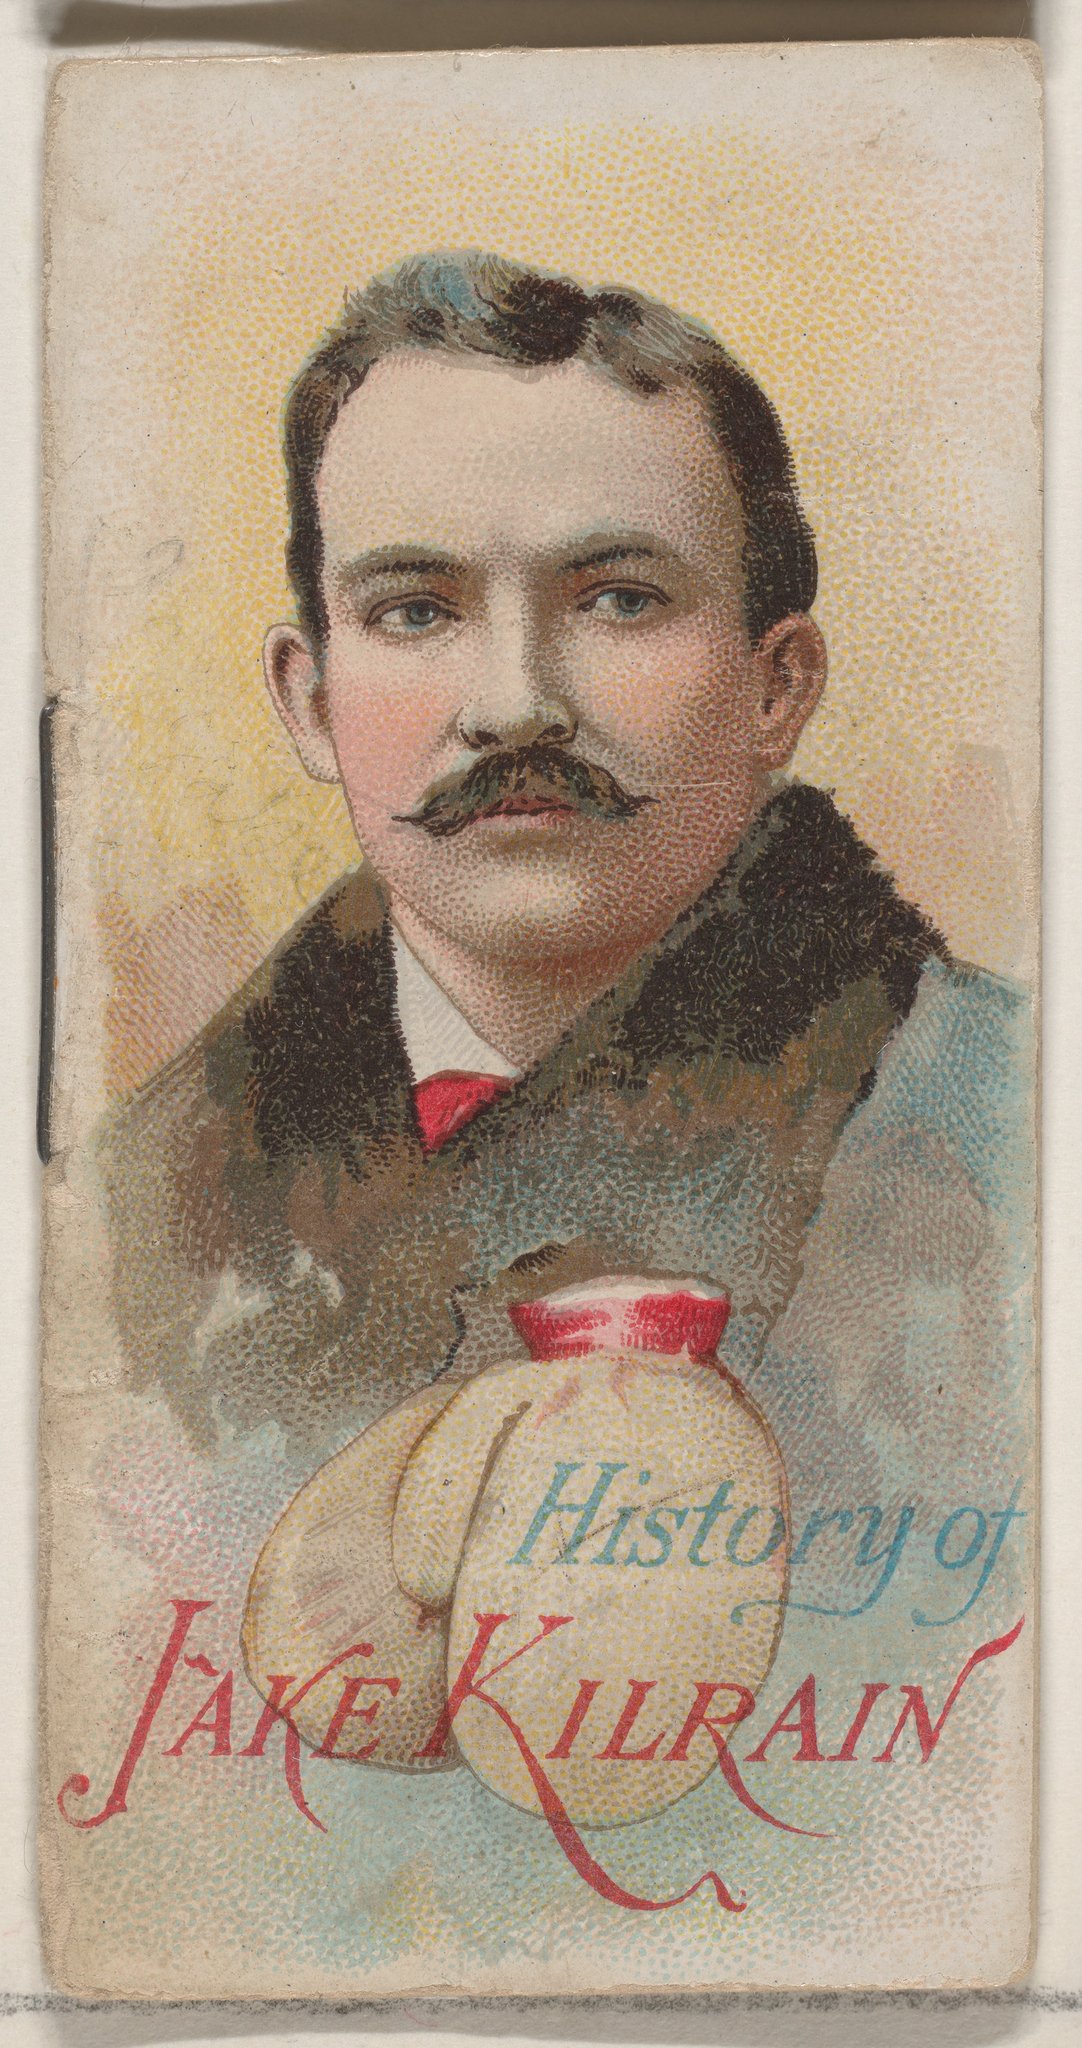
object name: print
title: History of Jake Kilrain, from the Histories of Poor Boys and Famous People series of booklets (N79) for Duke brand cigarettes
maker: w. duke, sons & co.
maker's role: publisher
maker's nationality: american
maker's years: 1870-1920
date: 1888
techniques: color lithograph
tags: men,portraits